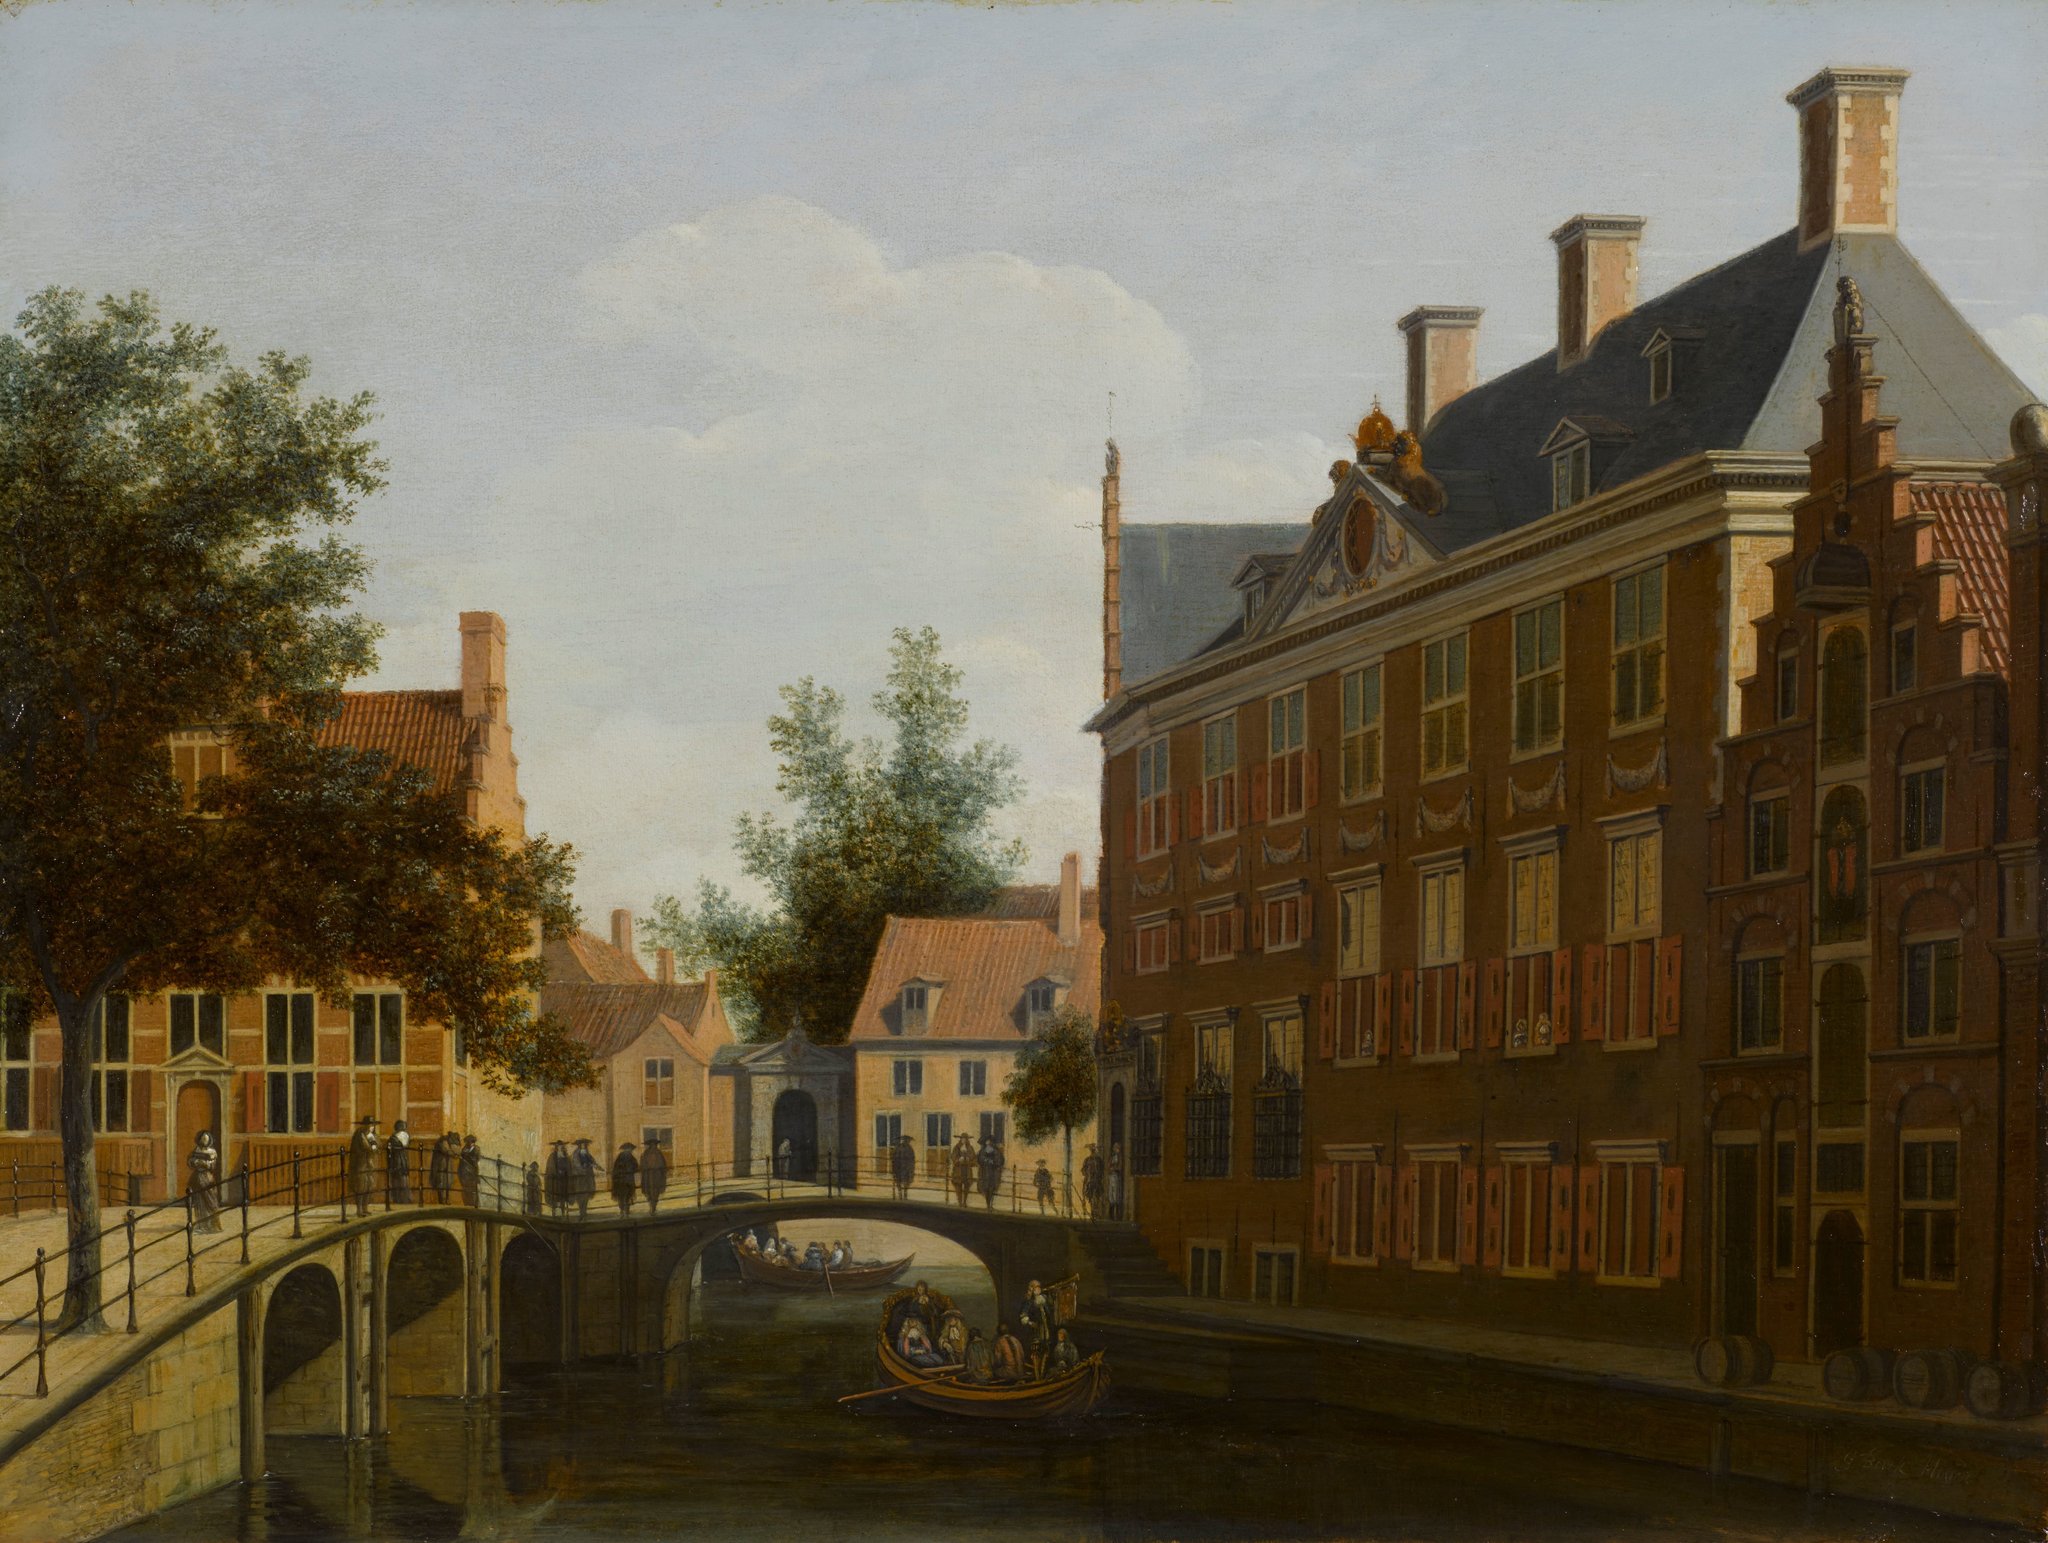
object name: painting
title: The Oude Zijds Herenlogement (Gentlemen's Hotel) in Amsterdam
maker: gerrit berckheyde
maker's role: draughtsman, painter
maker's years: 1638-1698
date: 1660-1680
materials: oil, panel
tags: canals, waters (in city), hotel, hostelry, inn, public road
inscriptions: signature: ‘G Berck Heyde’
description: Het Oude Zijds Herenlogement te Amsterdam, links het 'Huis aan de drie Grachten'.